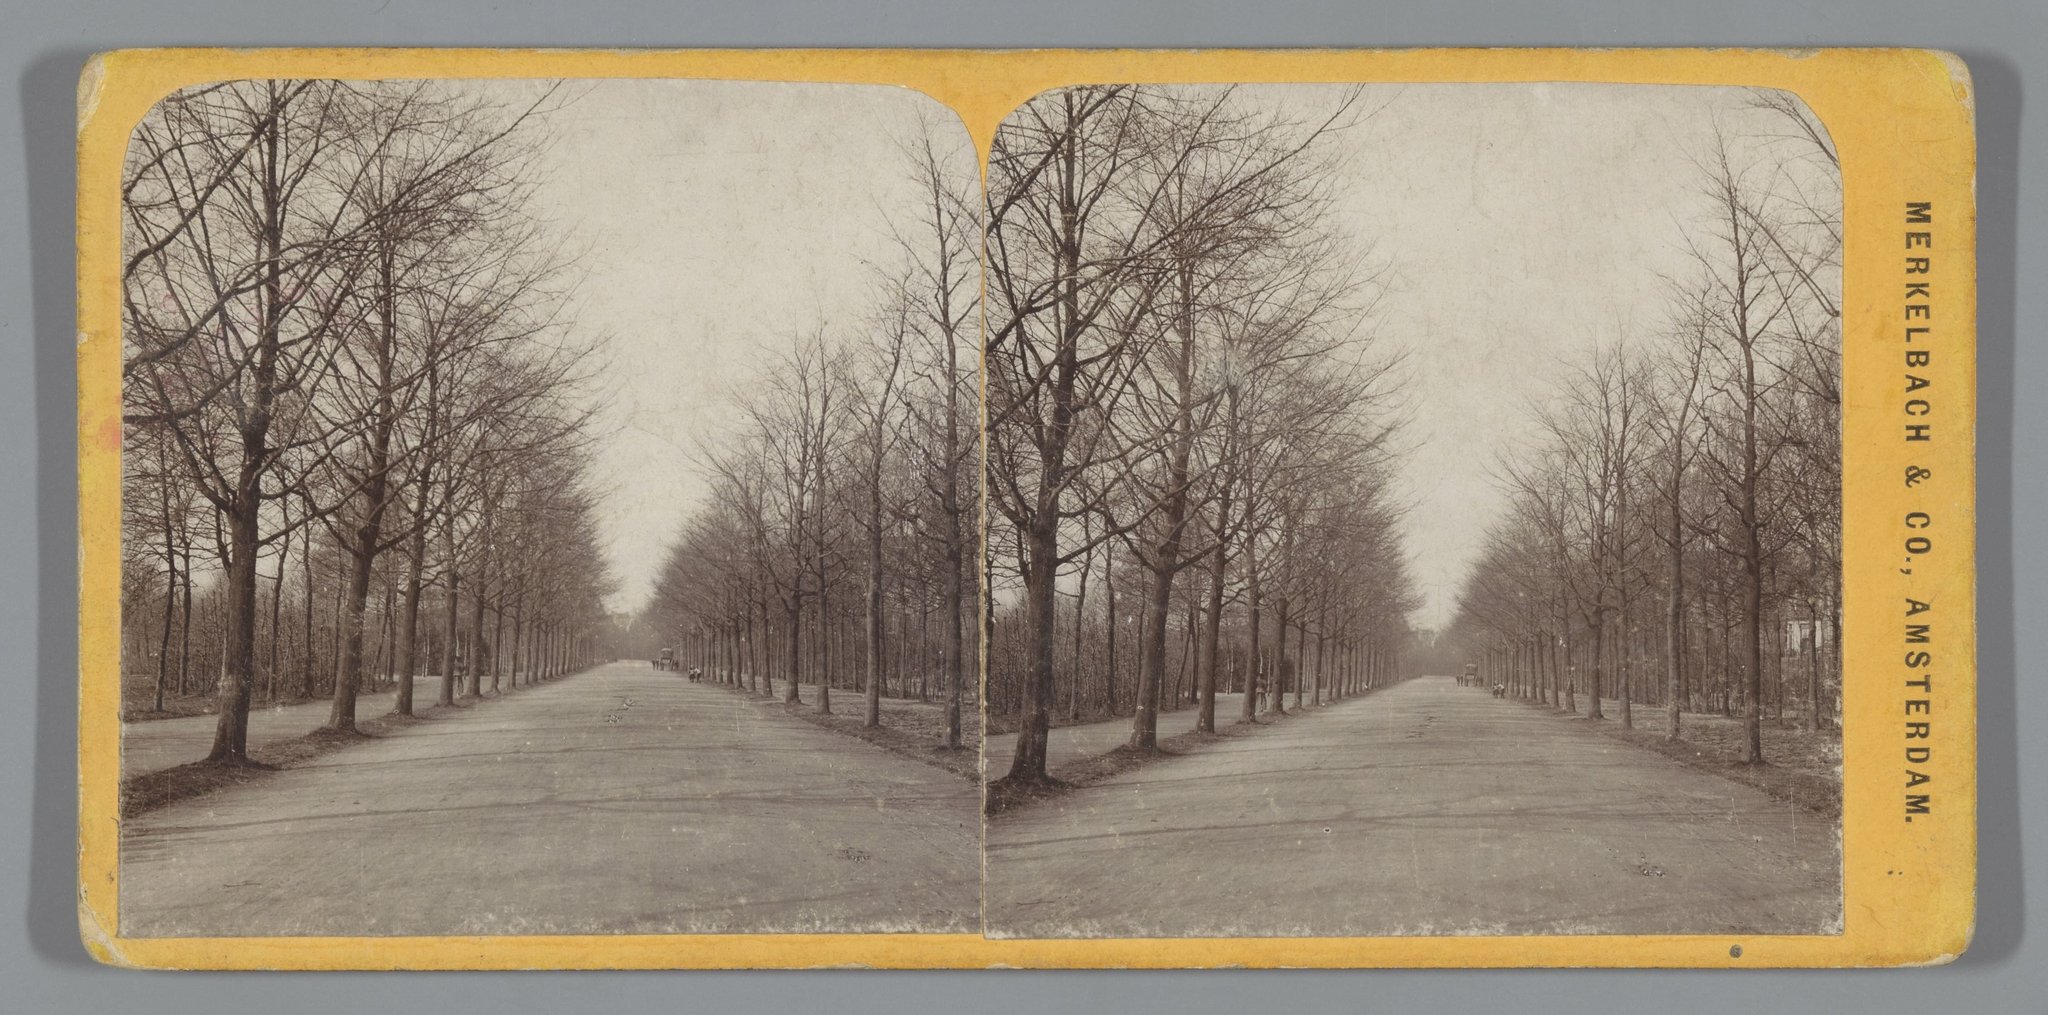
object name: stereograph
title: Laan in het Vondelpark, Amsterdam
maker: Anonymous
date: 1868-1890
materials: paper, cardboard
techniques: collodion silver print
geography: amsterdam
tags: park, forest path or lane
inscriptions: inscription: ‘Laan in het Vondelpark/ A'dam’